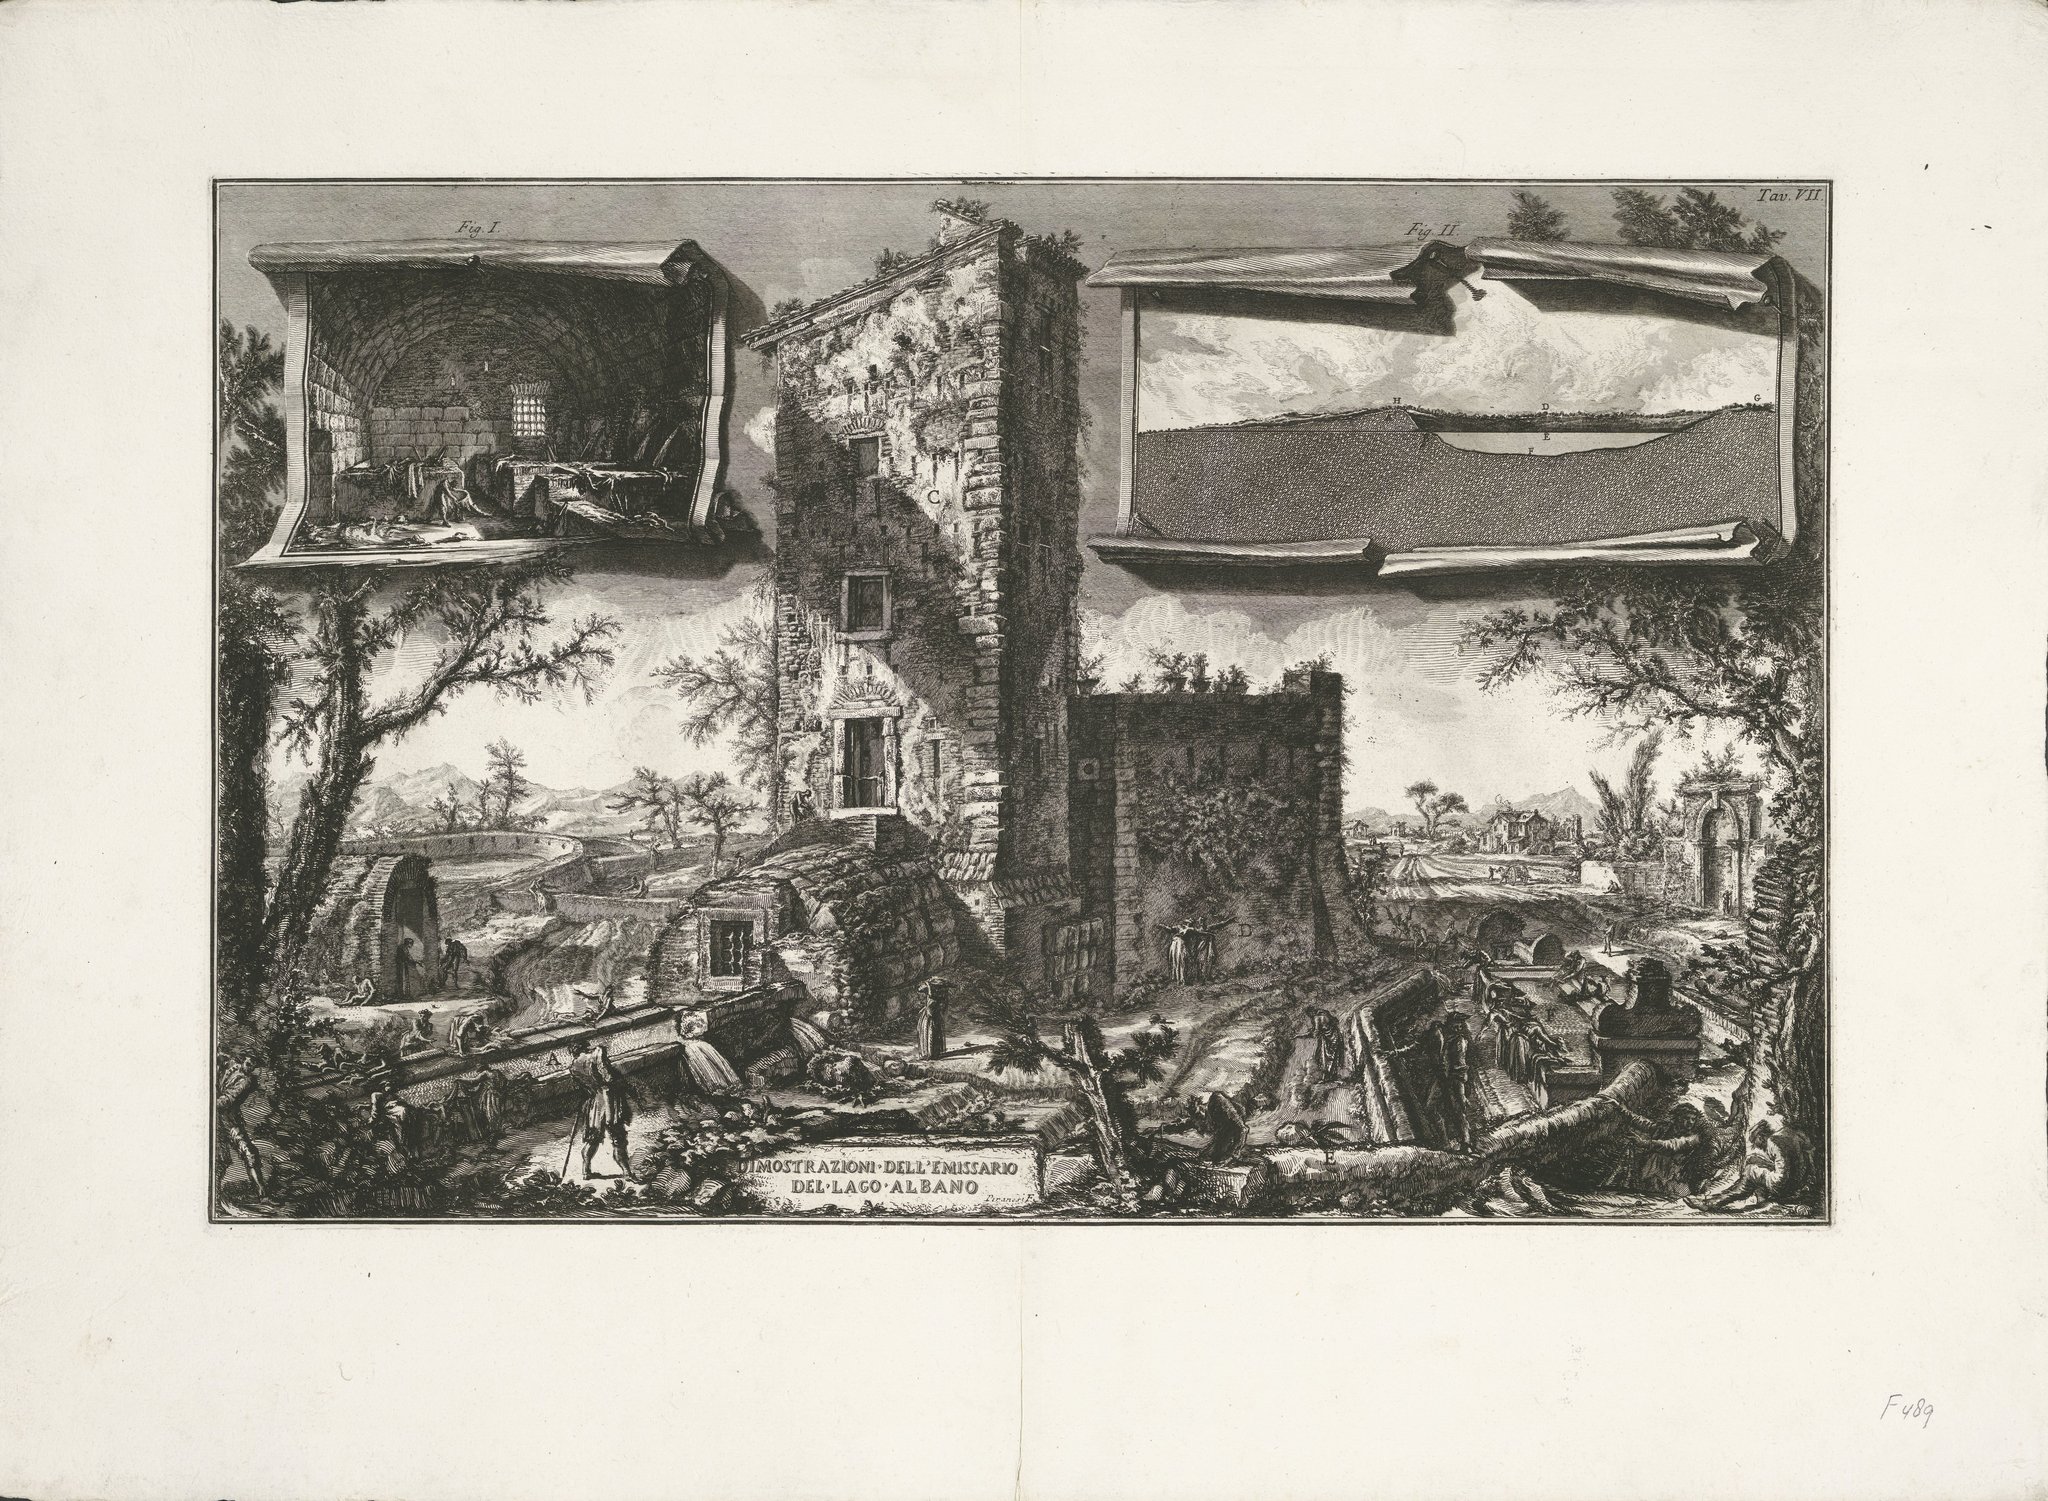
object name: print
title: Dimostrazioni dell'Emissario del Lago Albano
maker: giovanni battista piranesi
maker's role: designer, draughtsman, print maker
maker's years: 1720-1778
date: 1762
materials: paper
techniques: etching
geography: rome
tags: ruin of a building ~ architecture, sewers, lake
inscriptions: collector's mark: Lugt 2228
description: Gezicht op de resten van het afvoerkanaal van het Meer van Albano in een landschap, een gezicht in één van de bouwwerken en een doorsnede van het meer. Titel op steen midden onder. Genummerd boven: Tav. VII.